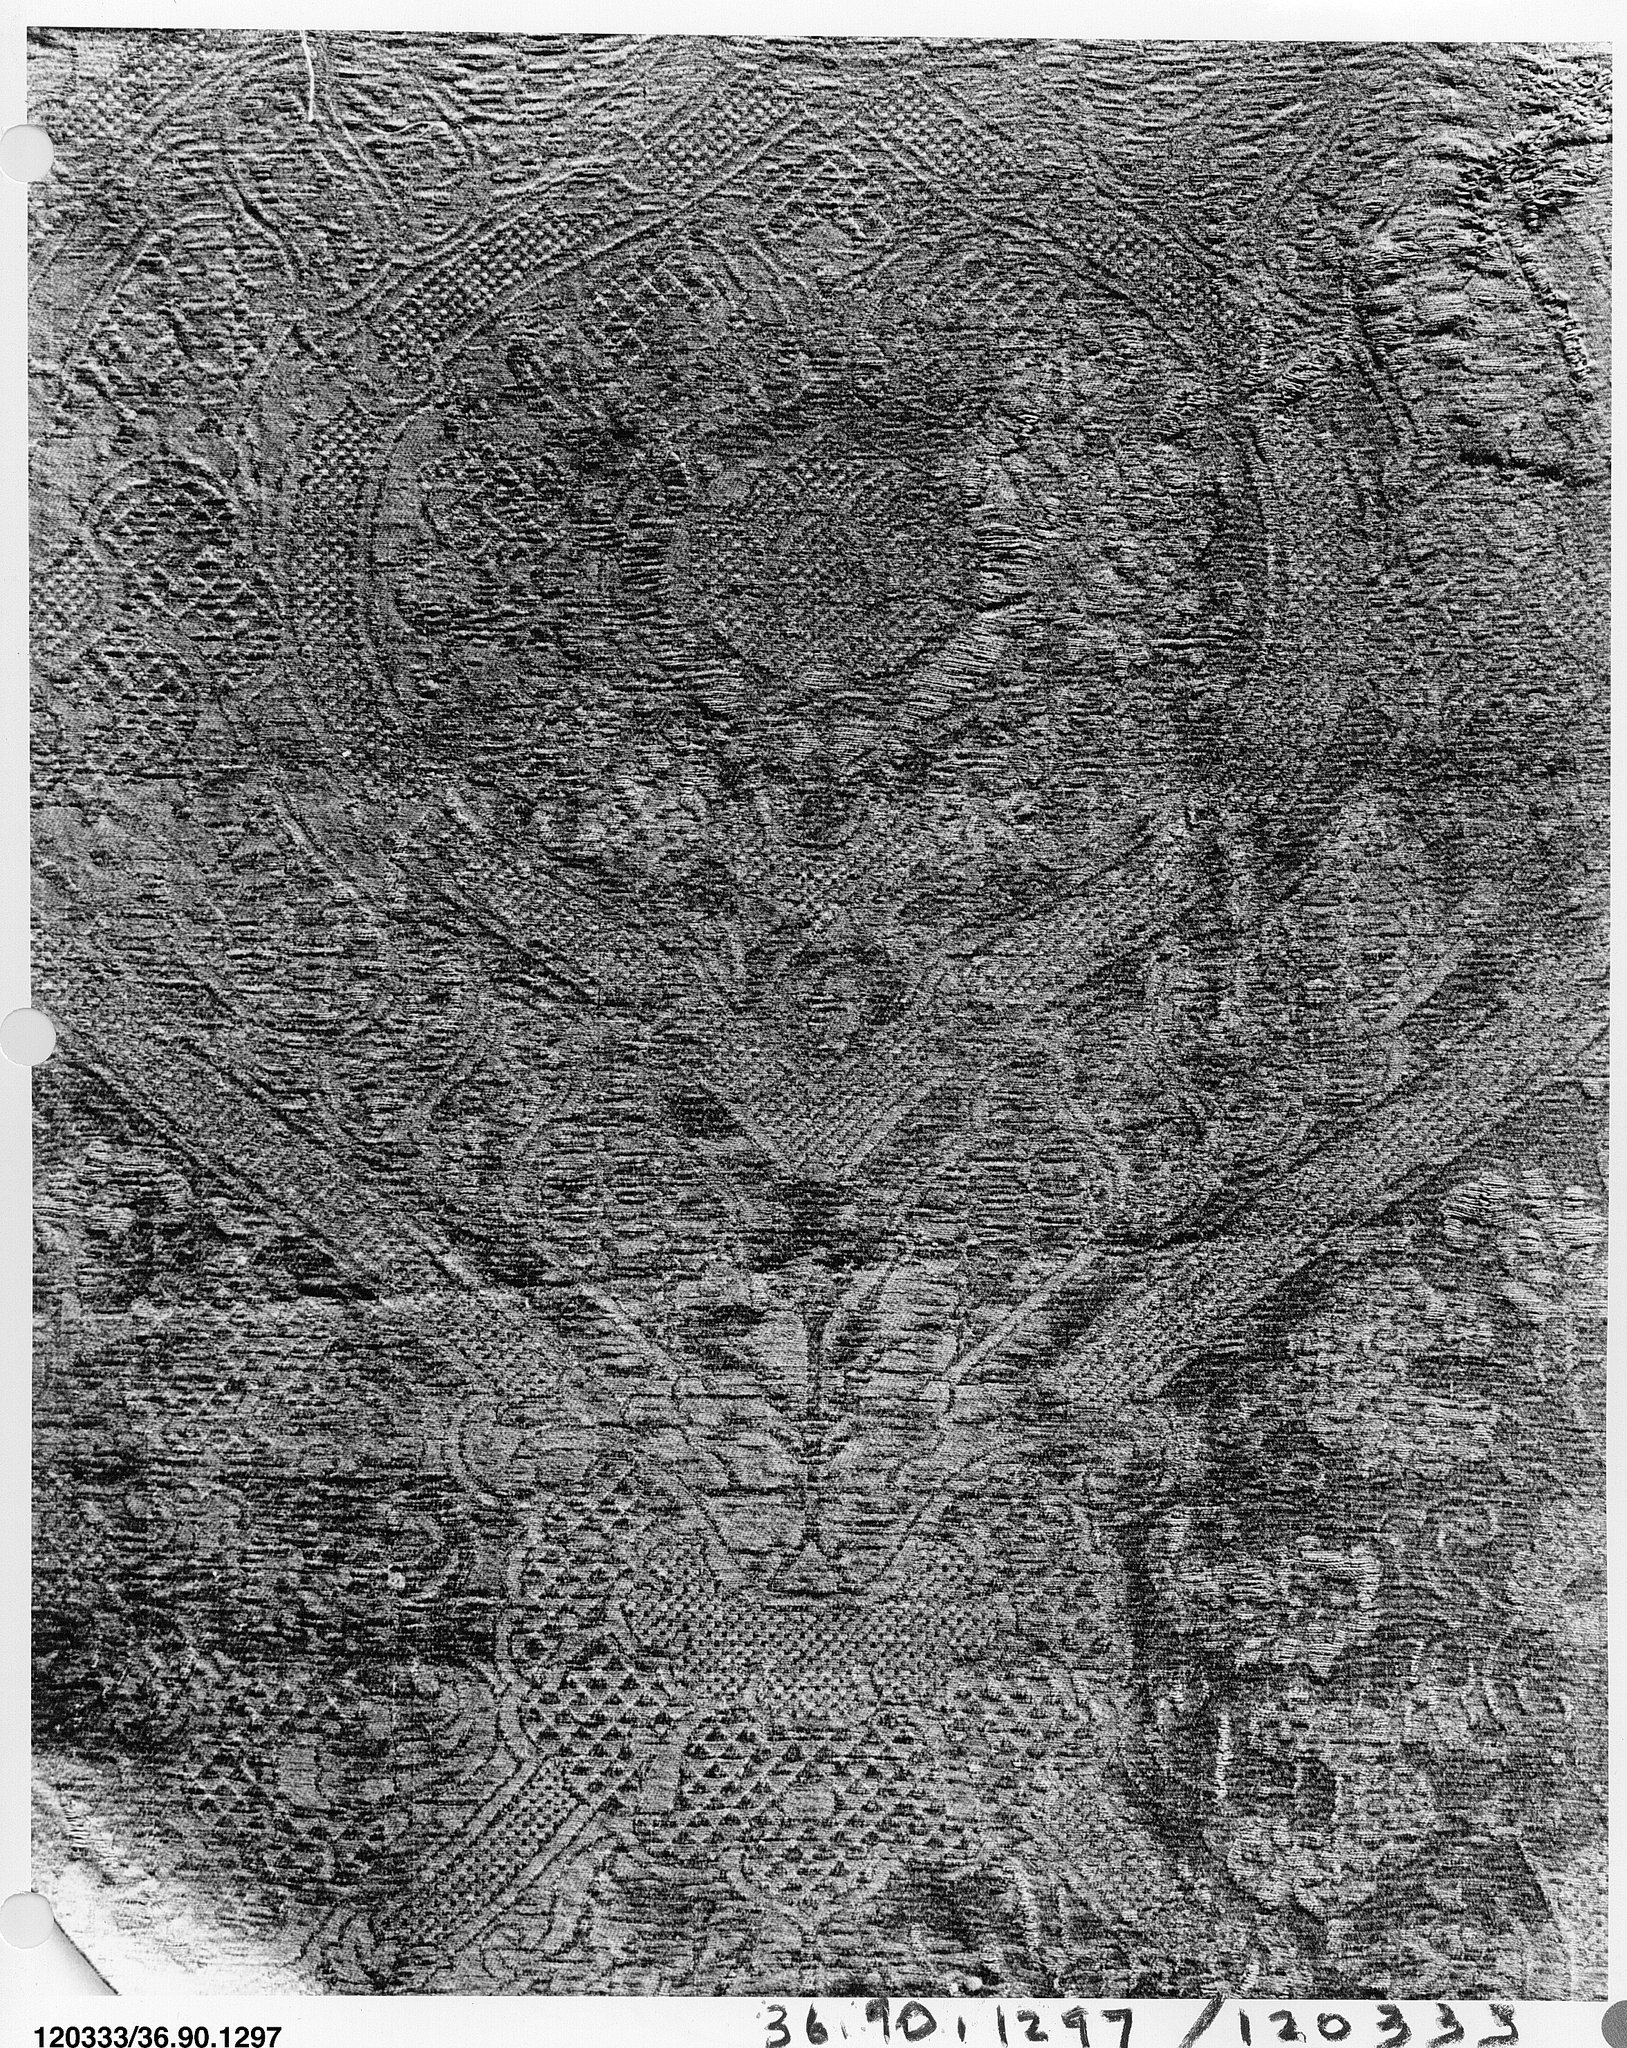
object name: piece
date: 1501-1600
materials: linen, silk